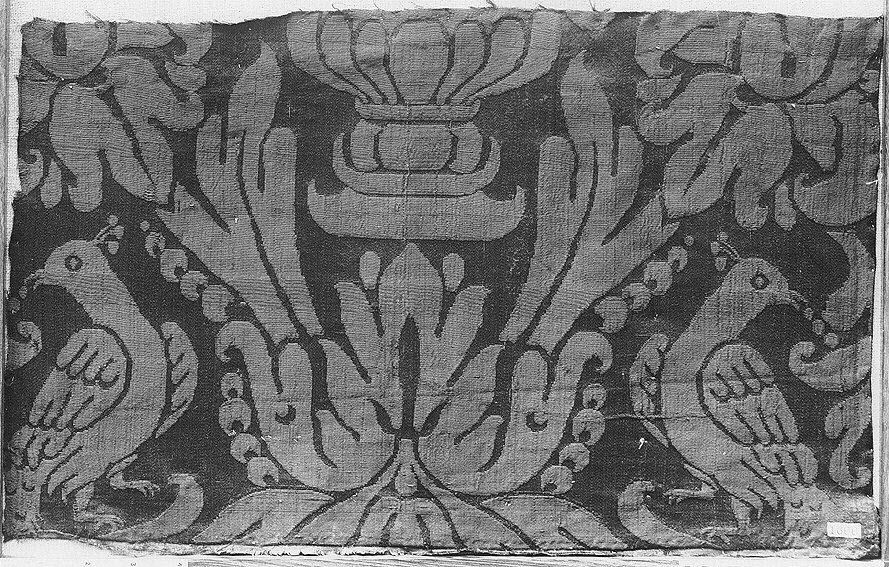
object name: piece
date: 1601-1700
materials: silk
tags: birds